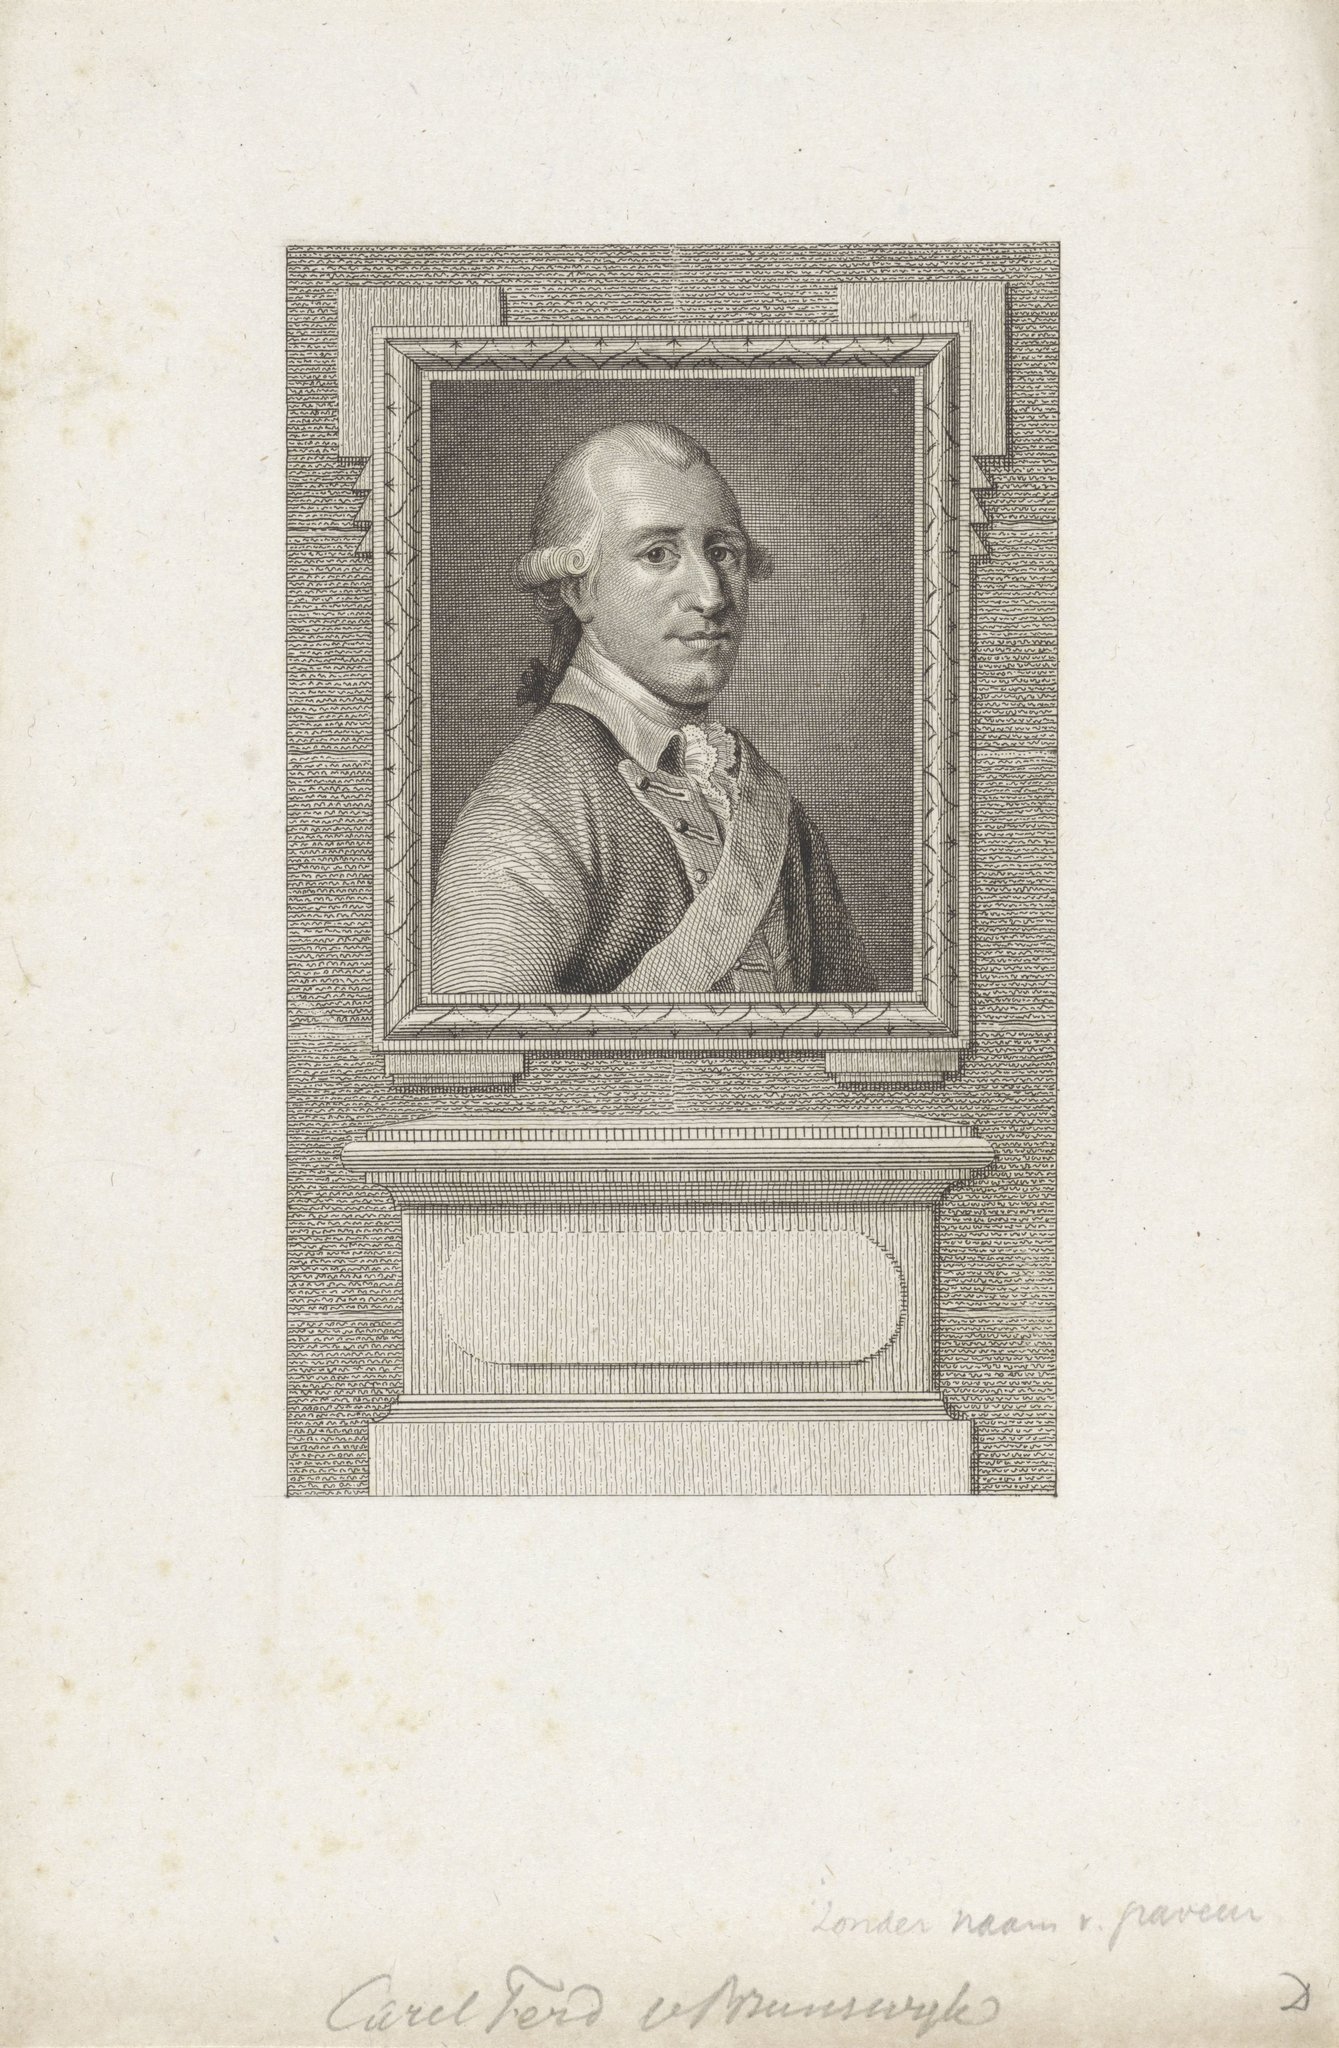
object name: print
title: Portret van Karel Willem Ferdinand hertog van Brunswijk-Wolfenbüttel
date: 1786-1809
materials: paper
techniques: etching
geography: amsterdam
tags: karel willem ferdinand hertog van brunswijk-wolfenbüttel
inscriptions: collector's mark: Lugt 2228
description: Latere staat prent gebruikt als boekillustratie in: Wagenaar, Jan. Vaderlandsche historie, (...) ten vervolge van Wagenaars Vaderlandsche historie. Dl. 1-43. Amsterdam: Johannes Allart, 1786-1809.